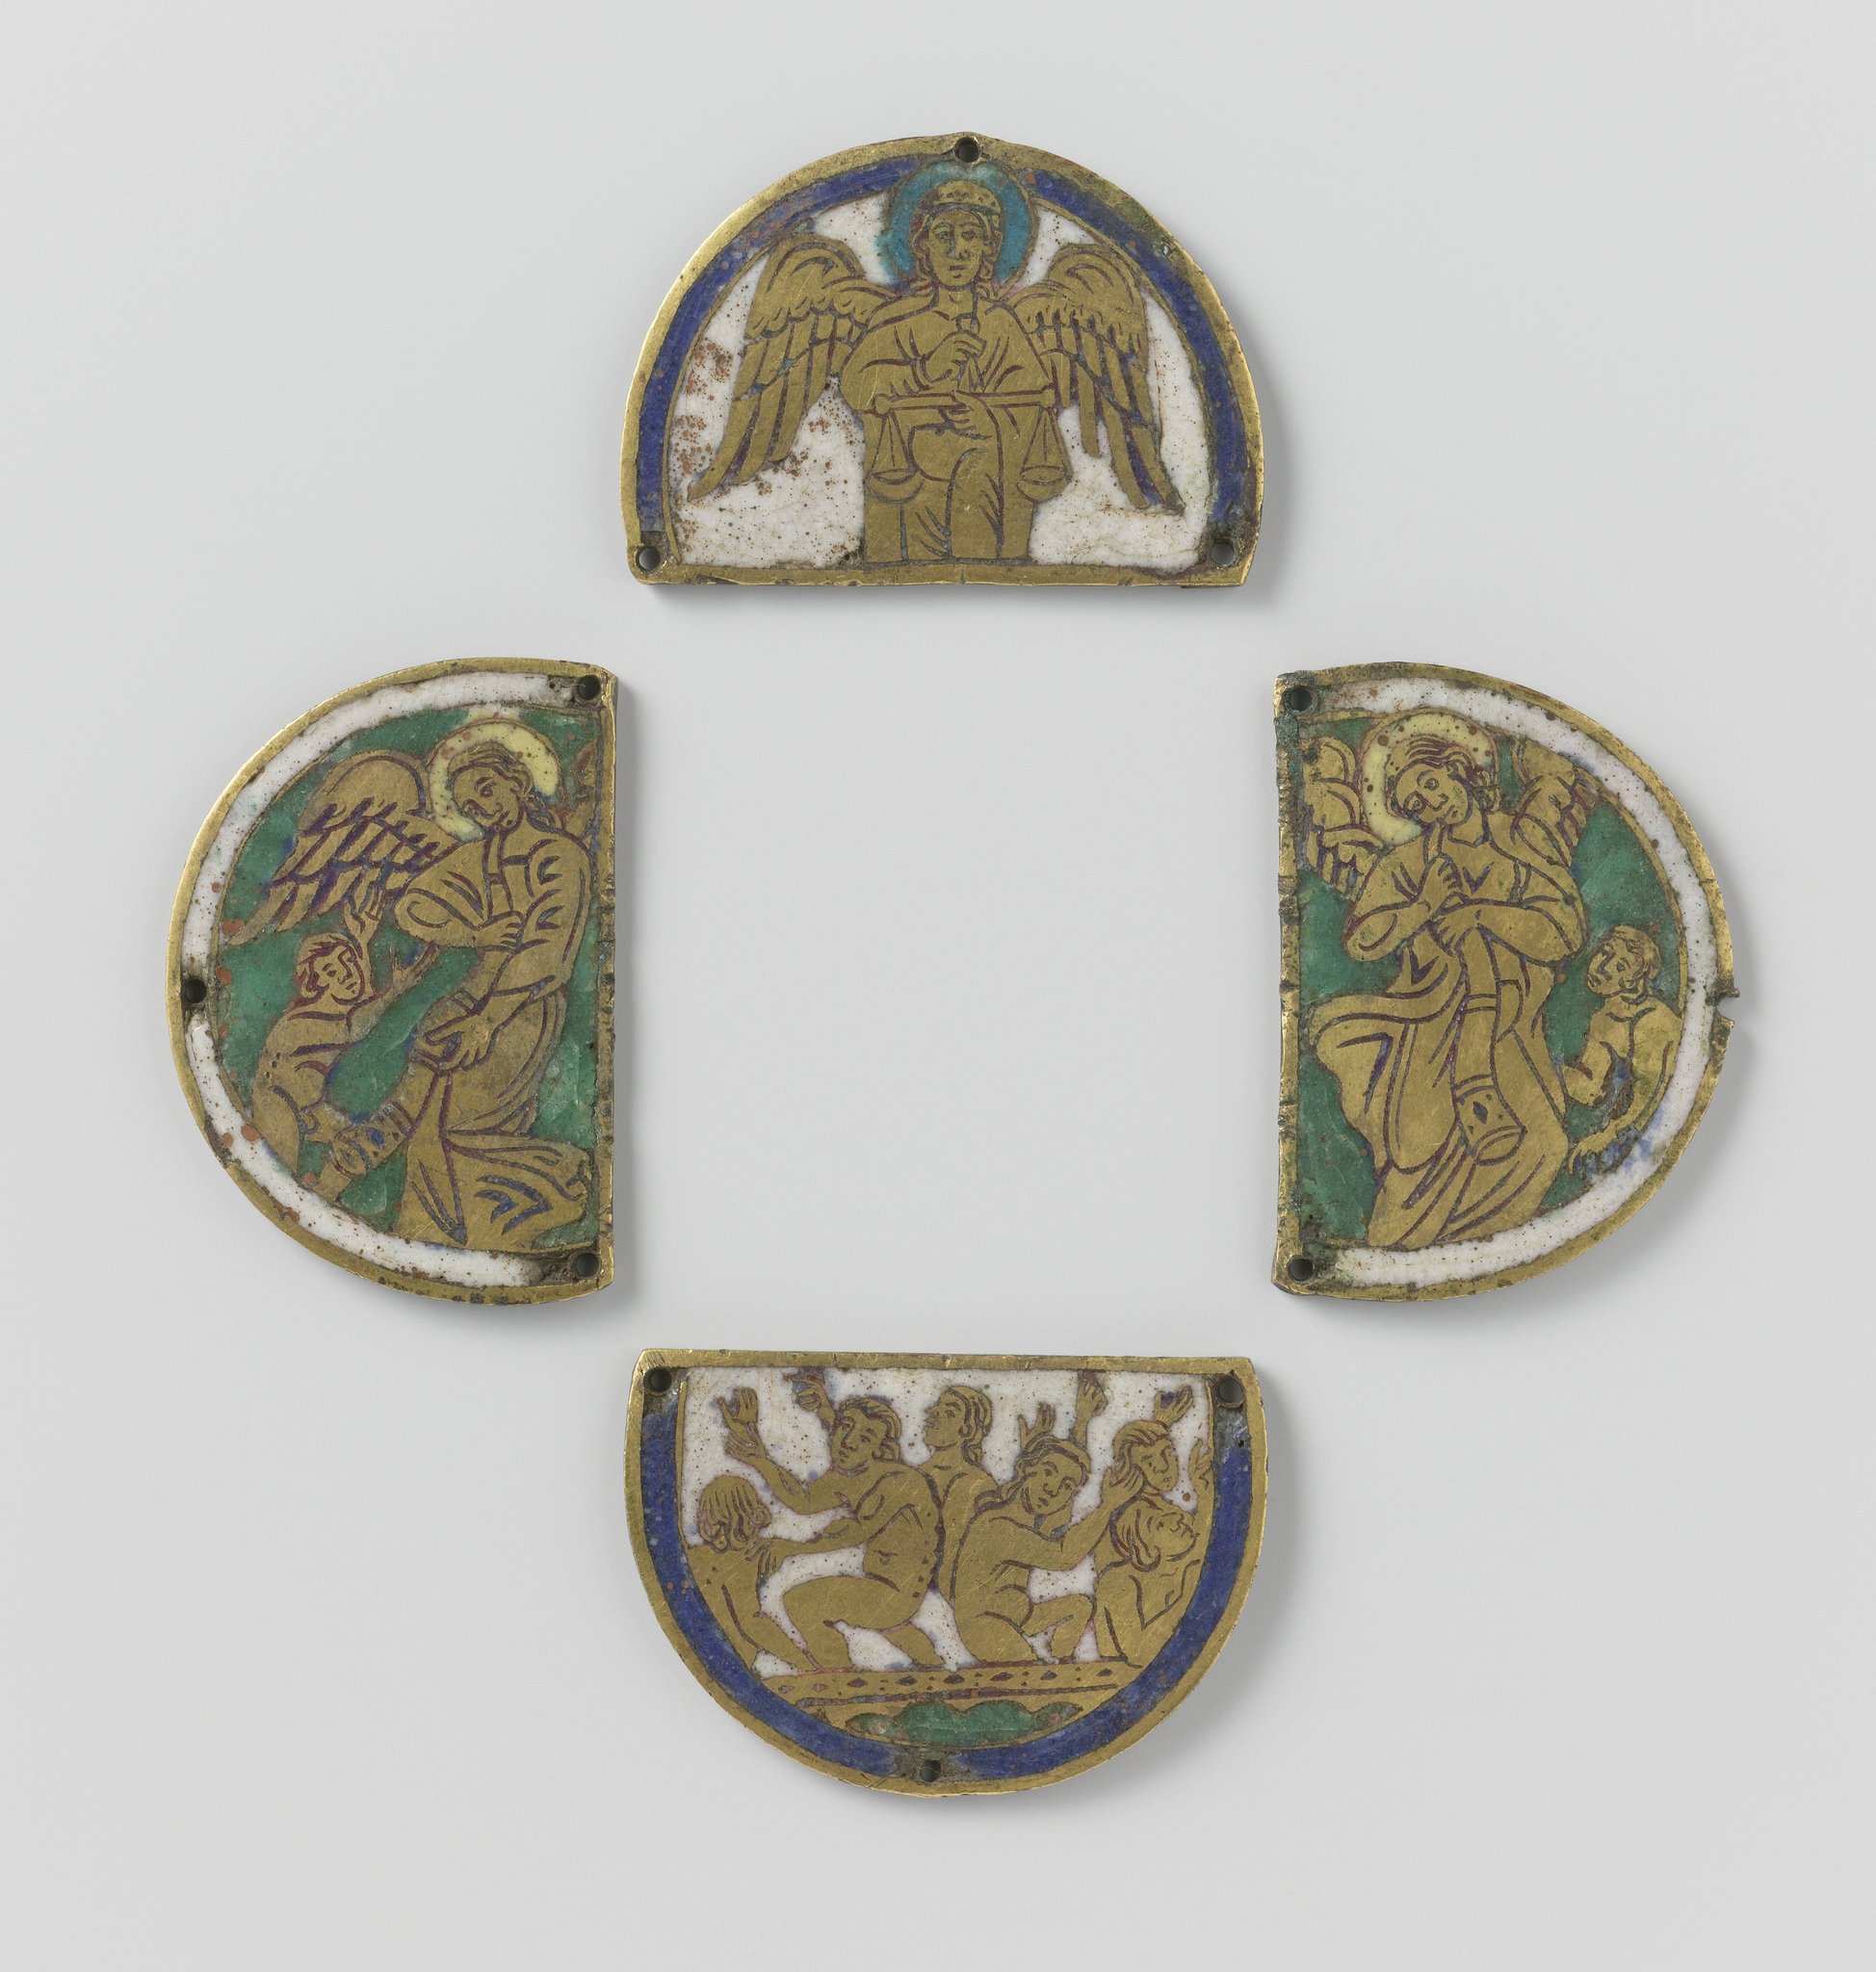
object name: plate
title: Vier plaquettes met voorstellingen die betrekking hebben op het Laatste Oordeel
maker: Anonymous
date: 1200-1300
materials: copper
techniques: enamel, gilding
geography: limoges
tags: separate scenes ~ last judgement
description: Vier plaques. Koper, email. Maasgebied, 13de eeuw.